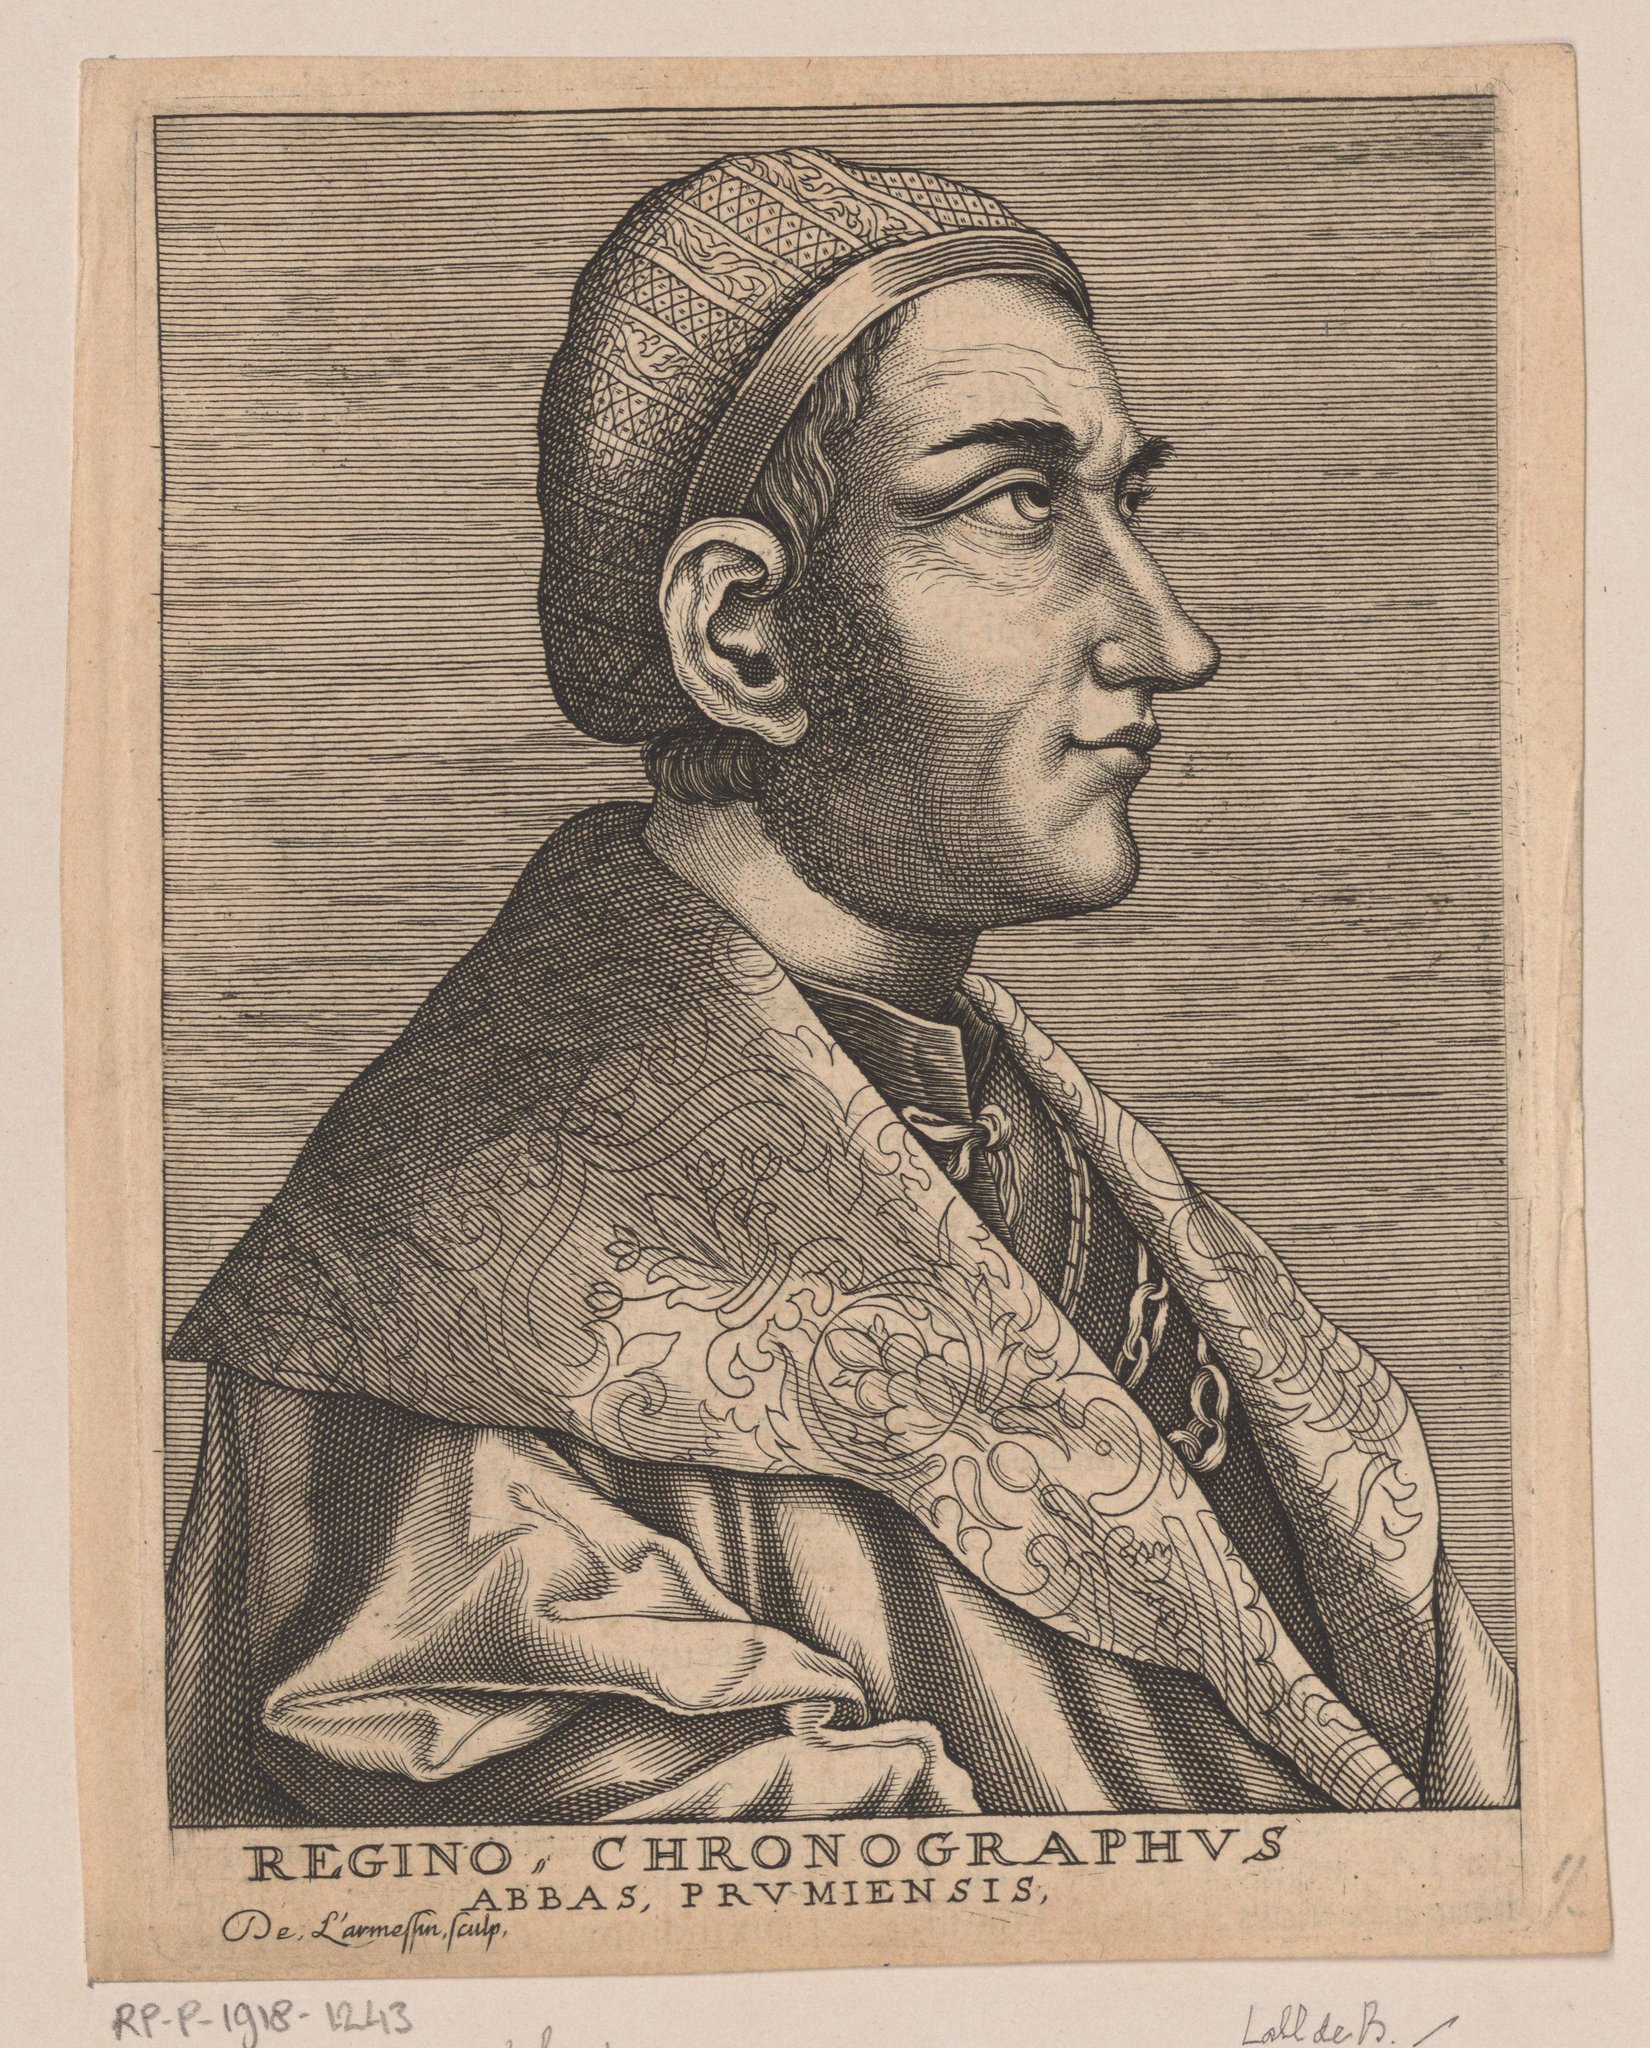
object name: print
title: Portret van Regino von Prüm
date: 1682-1695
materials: paper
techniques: engraving, letterpress printing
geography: brussels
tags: historical persons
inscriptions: collector's mark: Lugt 2233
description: Prent uit: Bullart, Isaac. Academie des sciences et des arts, contenant les vies, & les eloges historiques des hommes illustres. Brussel: François Foppens, 1682, dl. 1. Of een latere publicatie (1695).